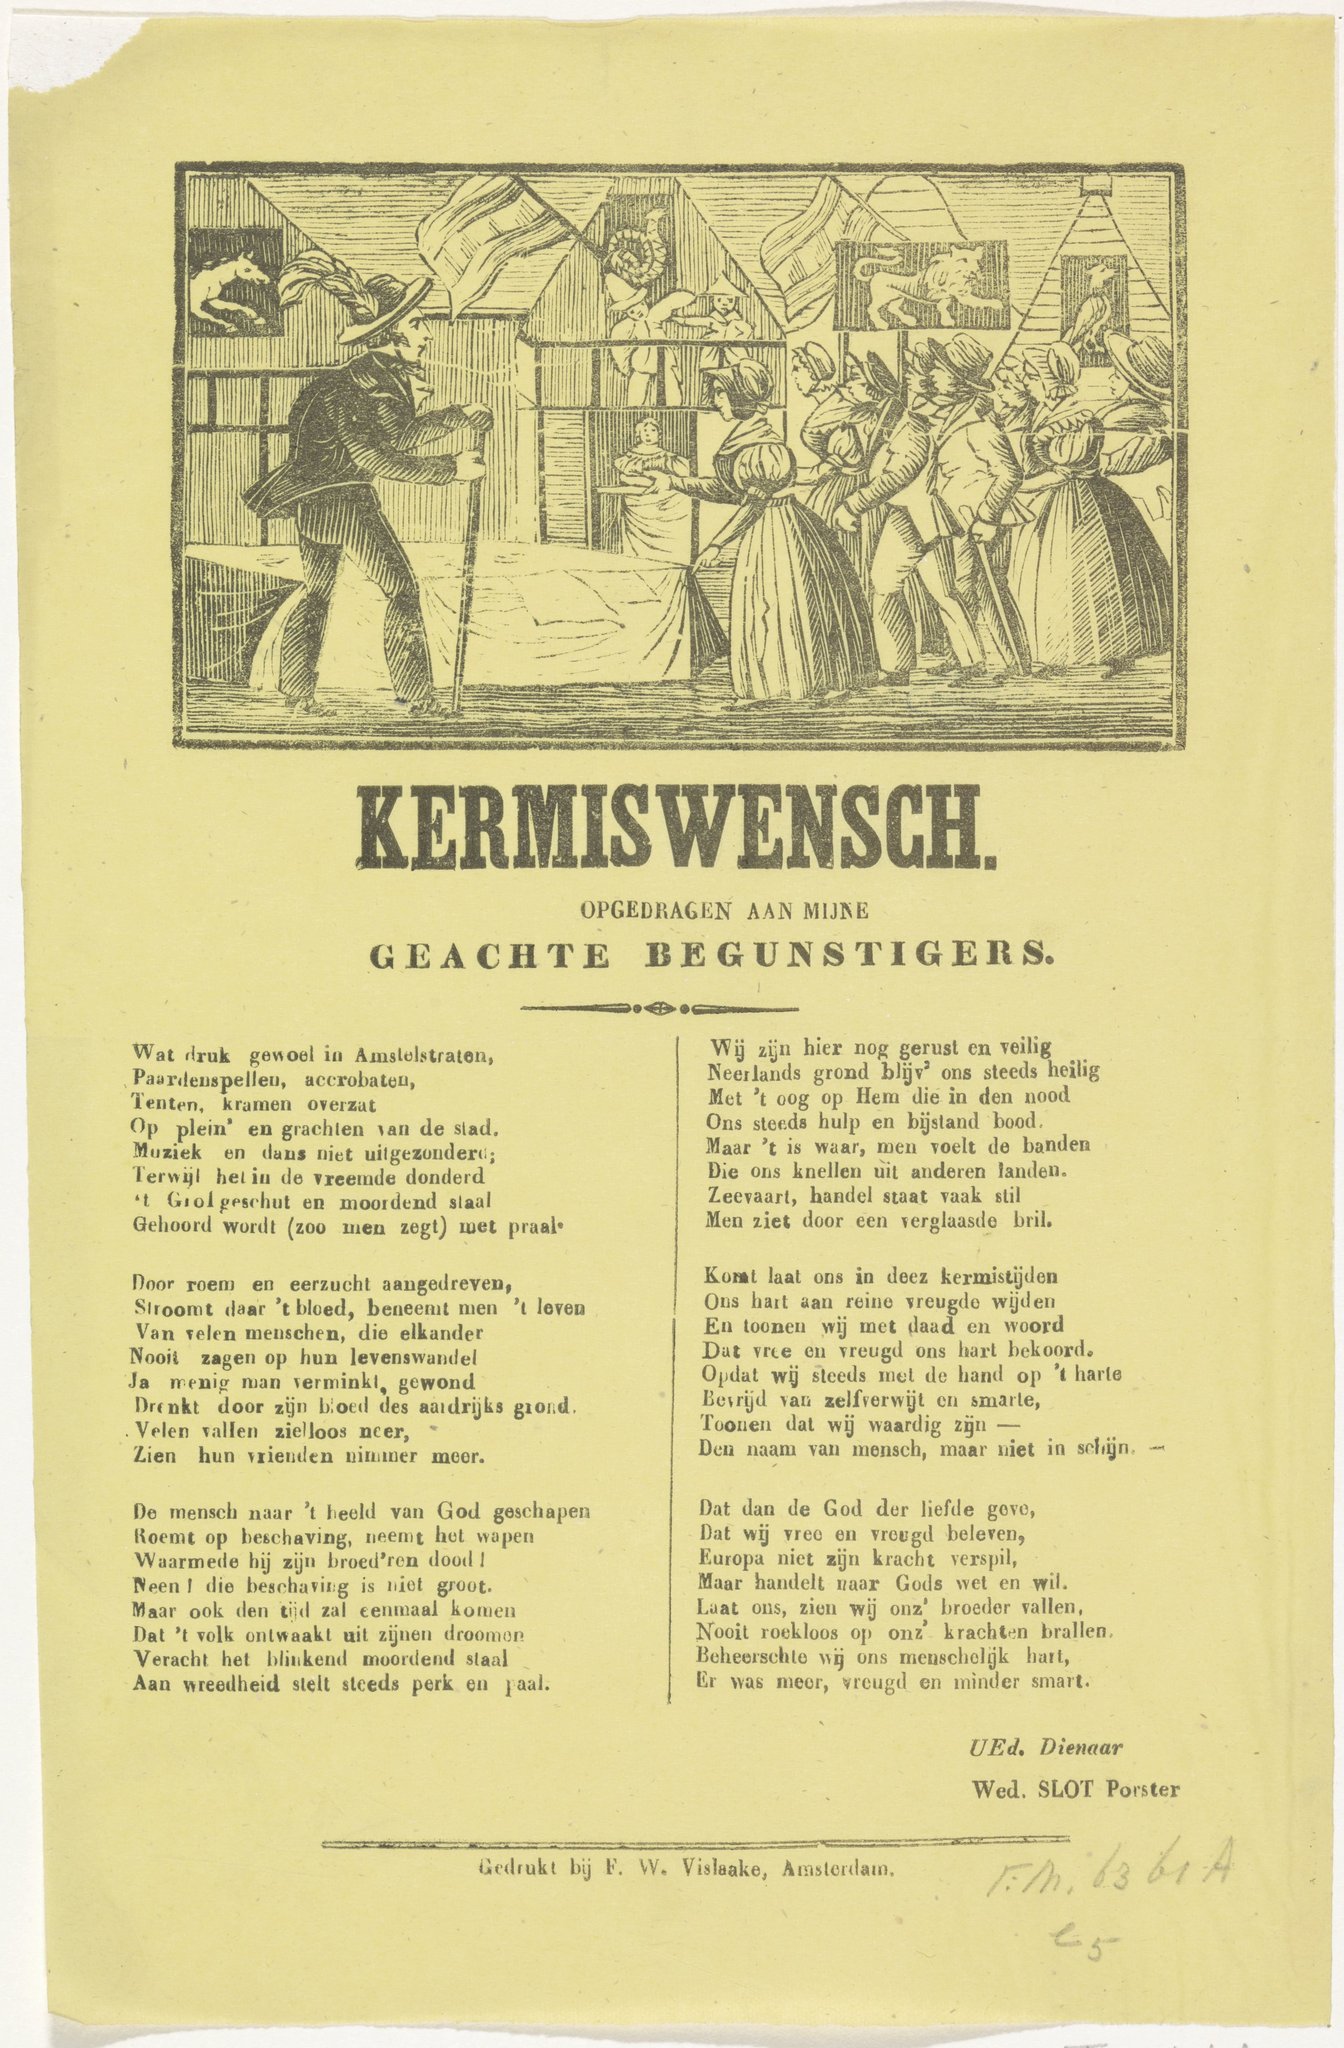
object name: fair print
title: Kermisprent van de Amsterdamse porsters, ca. 1860-1870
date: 1860-1870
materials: paper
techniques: letterpress printing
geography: amsterdam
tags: government services, public services, waking up, pleasure fair and circus, amsterdam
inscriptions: collector's mark: Lugt 2228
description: Kermisprent van de Amsterdamse porsters (wekkers), ca. 1860-1870. Gezicht op de Amsterdamse kermis. Met een vers in twee kolommen. Namens de porster: de weduwe Slot.